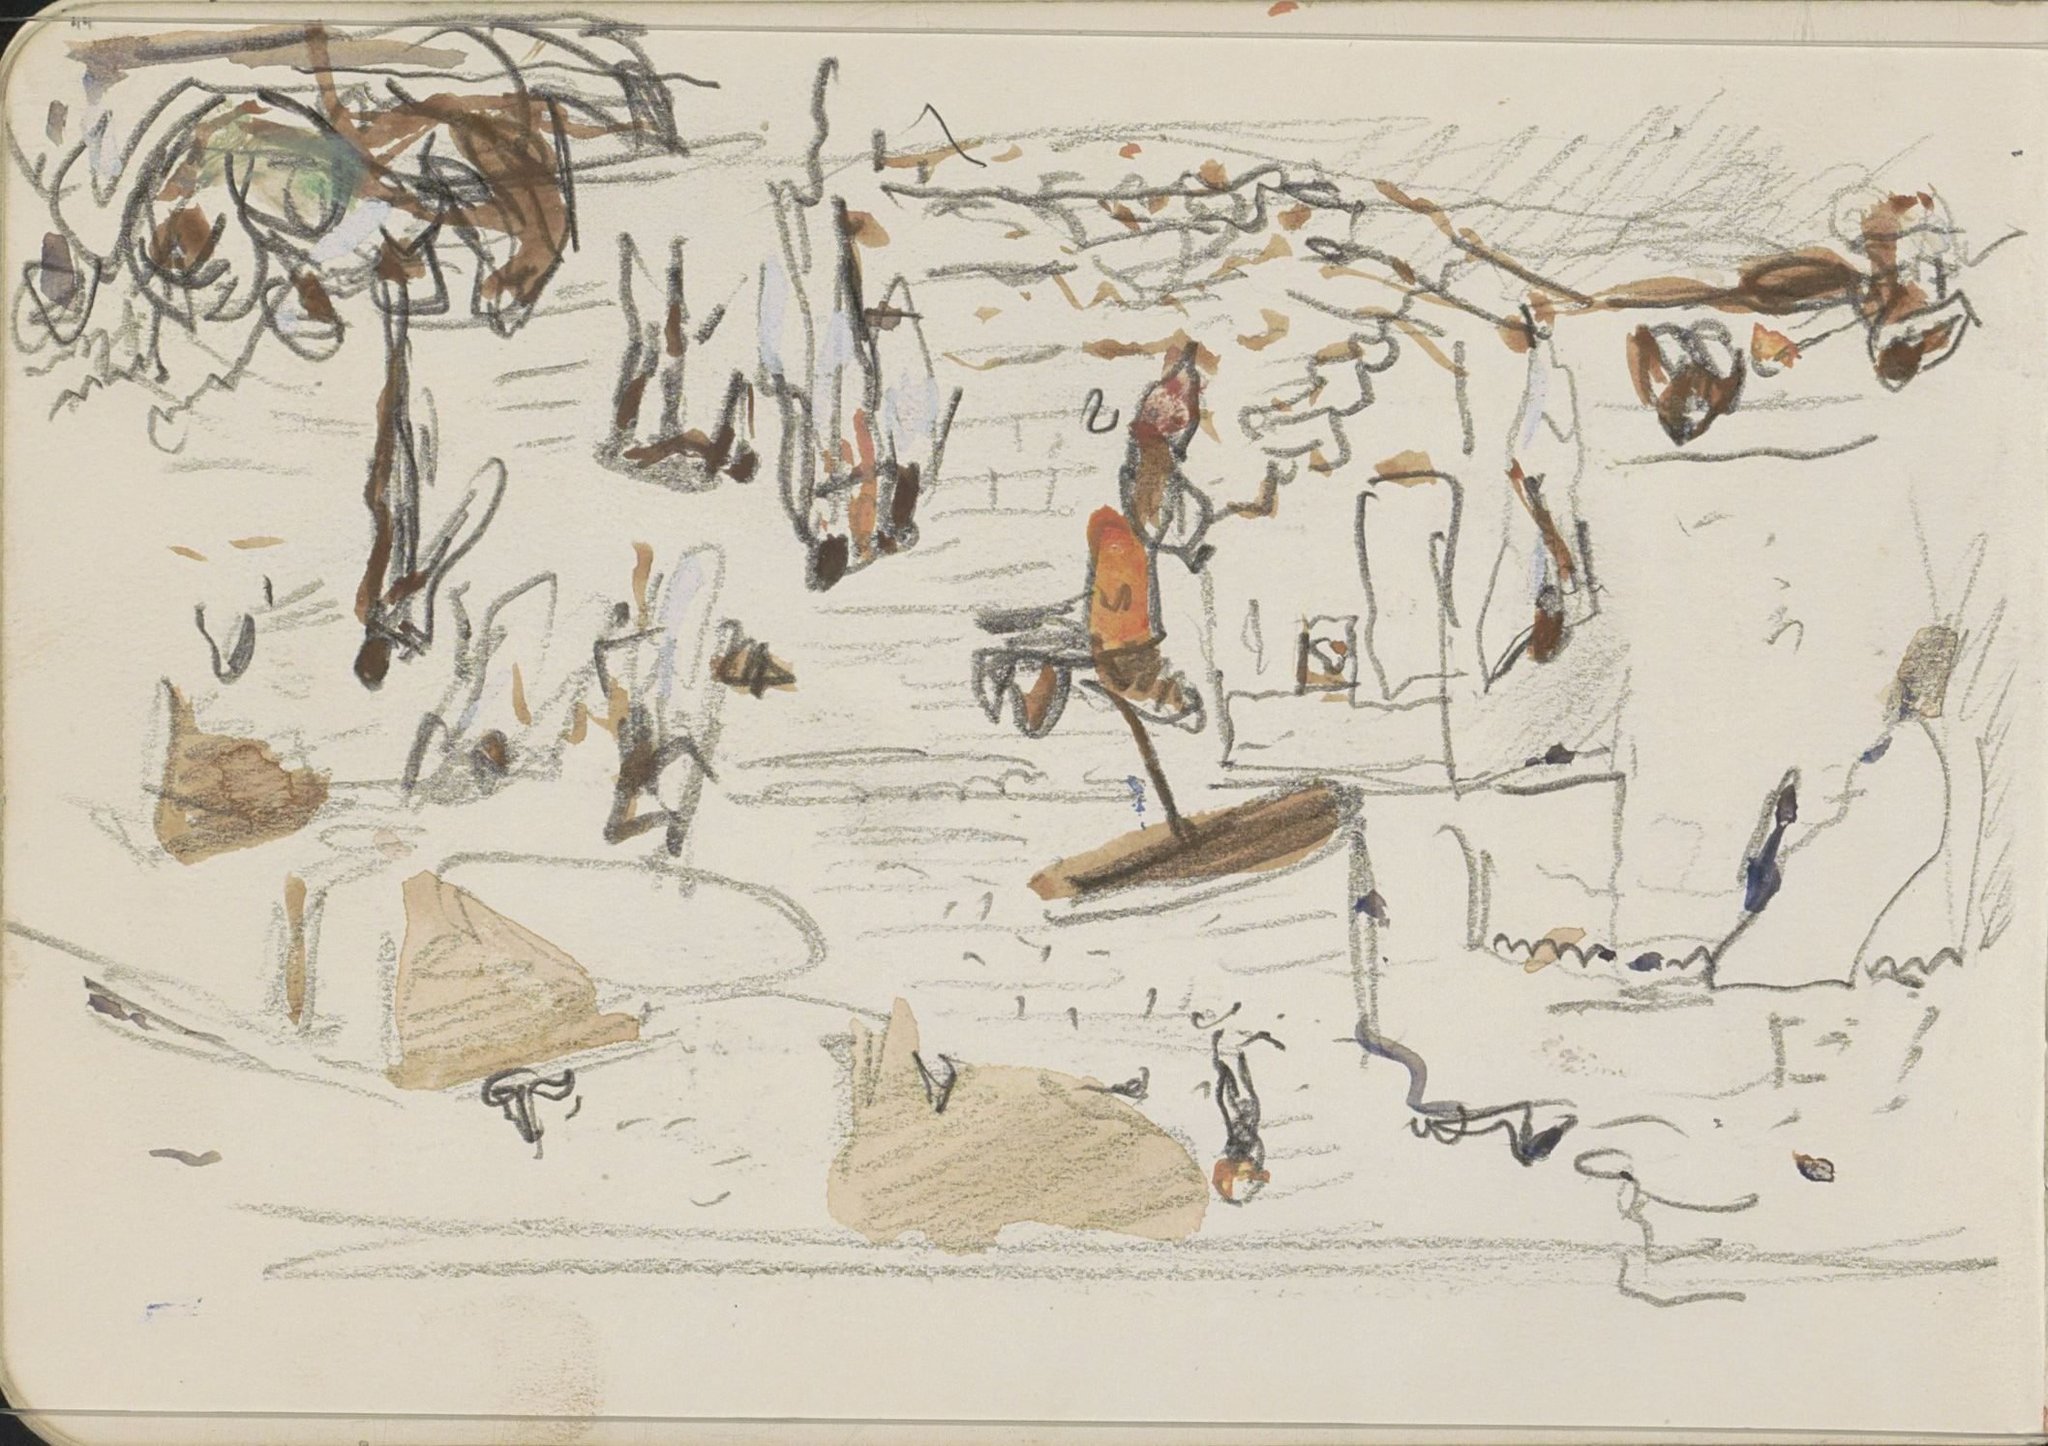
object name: sketchbook leaf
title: Badende Indiërs bij een trap aan de Ganges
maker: marius bauer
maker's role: draughtsman, print maker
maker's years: 1867-1932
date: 1924-1925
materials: paper, pencil, watercolor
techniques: brush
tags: flight of steps, river, rowing-boat, canoe, etc., asiatic races and peoples: indians, parasol, sunshade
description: Enkele van de figuren zit onder een parasol op de trap naar de rivier. Op de voorgrond een boot met figuren. Pagina 44 uit een schetsboek met 23 bladen.